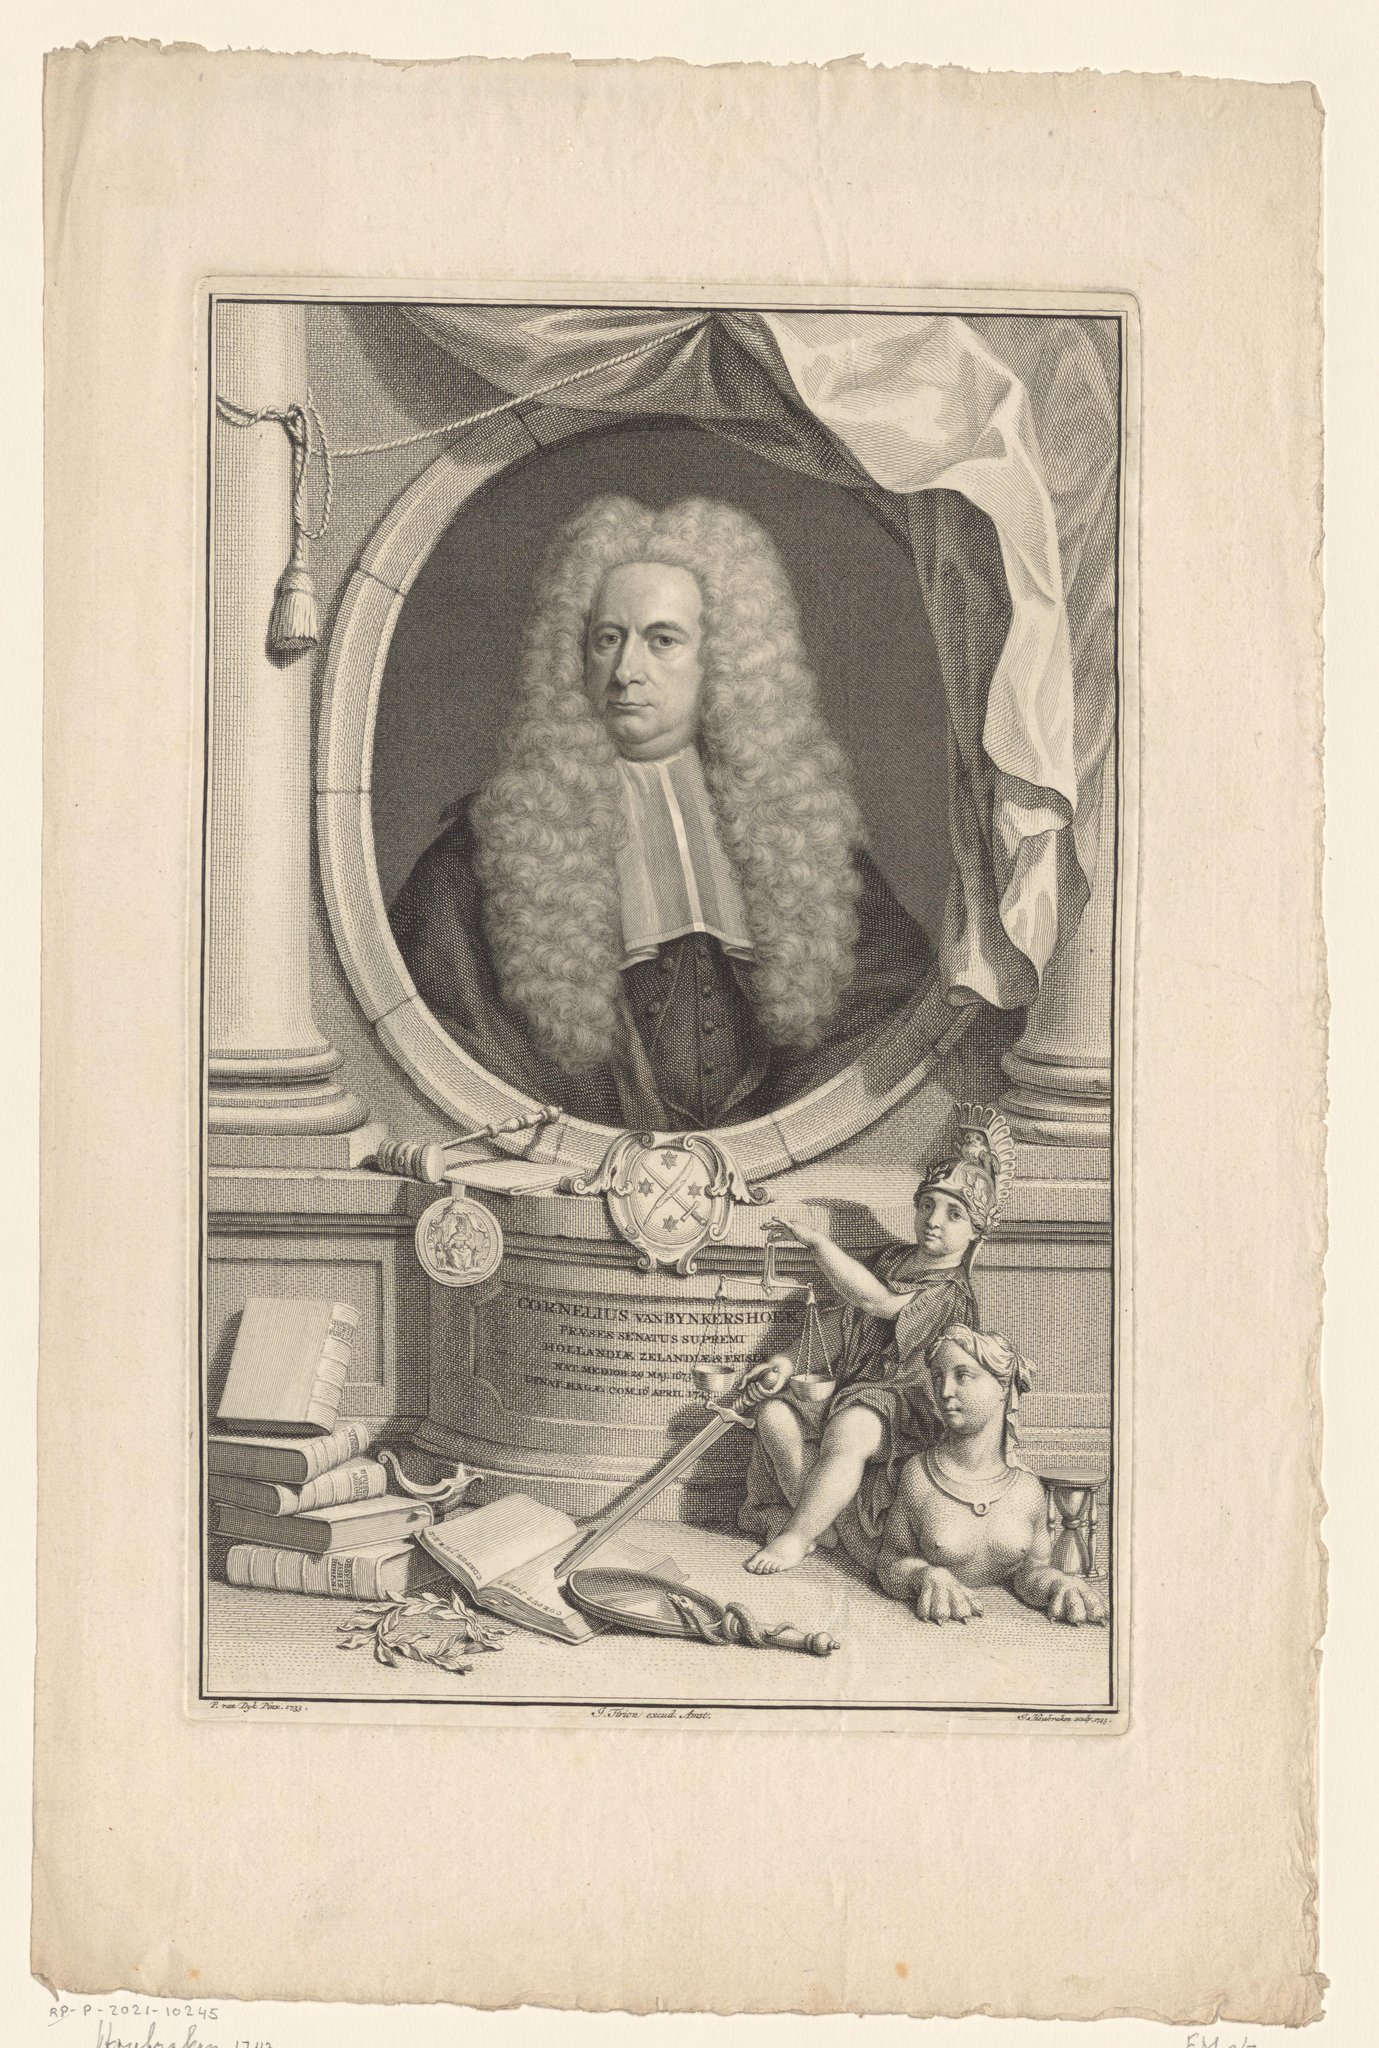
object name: print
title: Portret van Cornelis van Bynkershoek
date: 1743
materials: paper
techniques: engraving, etching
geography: amsterdam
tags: sphinx (lion/woman); 'sfinge' (ripa), historical persons, book, armorial bearing, heraldry, symbols and allegories of jurisprudence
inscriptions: collector's mark: Lugt 2228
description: Met onder het portret zijn wapenschild. Op de voorgrond de personificatie van de rechtspraak, gezeten op de rug van een sfinx. Links op de voorgrond boeken over de rechtspraak, een lauwerkrans en een spiegel met een slang rond het handvat.